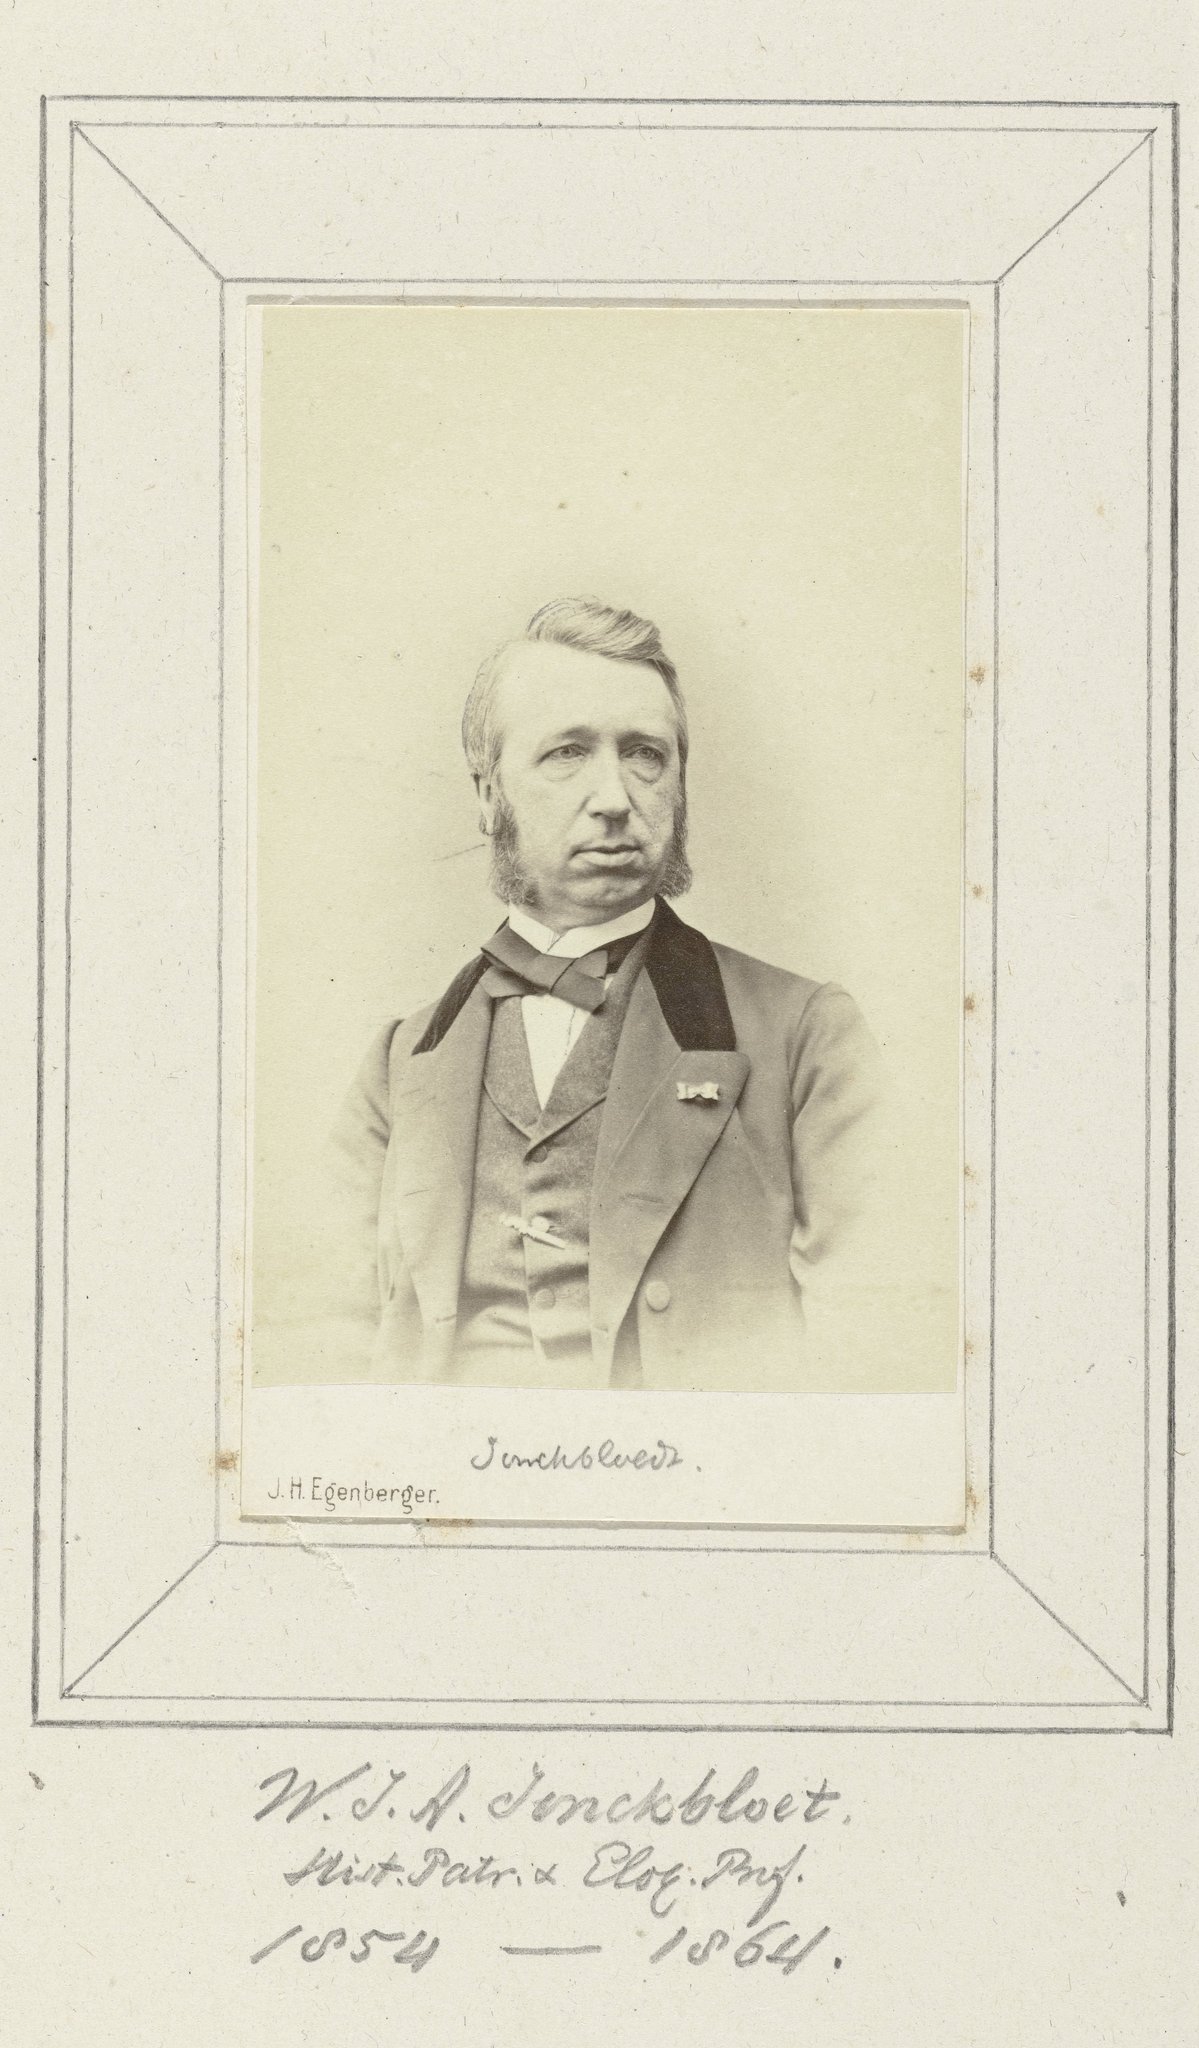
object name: carte de visite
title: W.J.A. Jonckbloet Hist. Patr. Elog Prof. 1854-1864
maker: johannes hinderikus egenberger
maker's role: draughtsman, print maker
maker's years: 1822-1897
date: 1860-1864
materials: paper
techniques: albumen print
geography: utrecht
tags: historical persons (portraits and scenes from the life)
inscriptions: name: ‘W.J.A. Jonckbloet Hist. Patr. Elog Prof. 1854-1864’